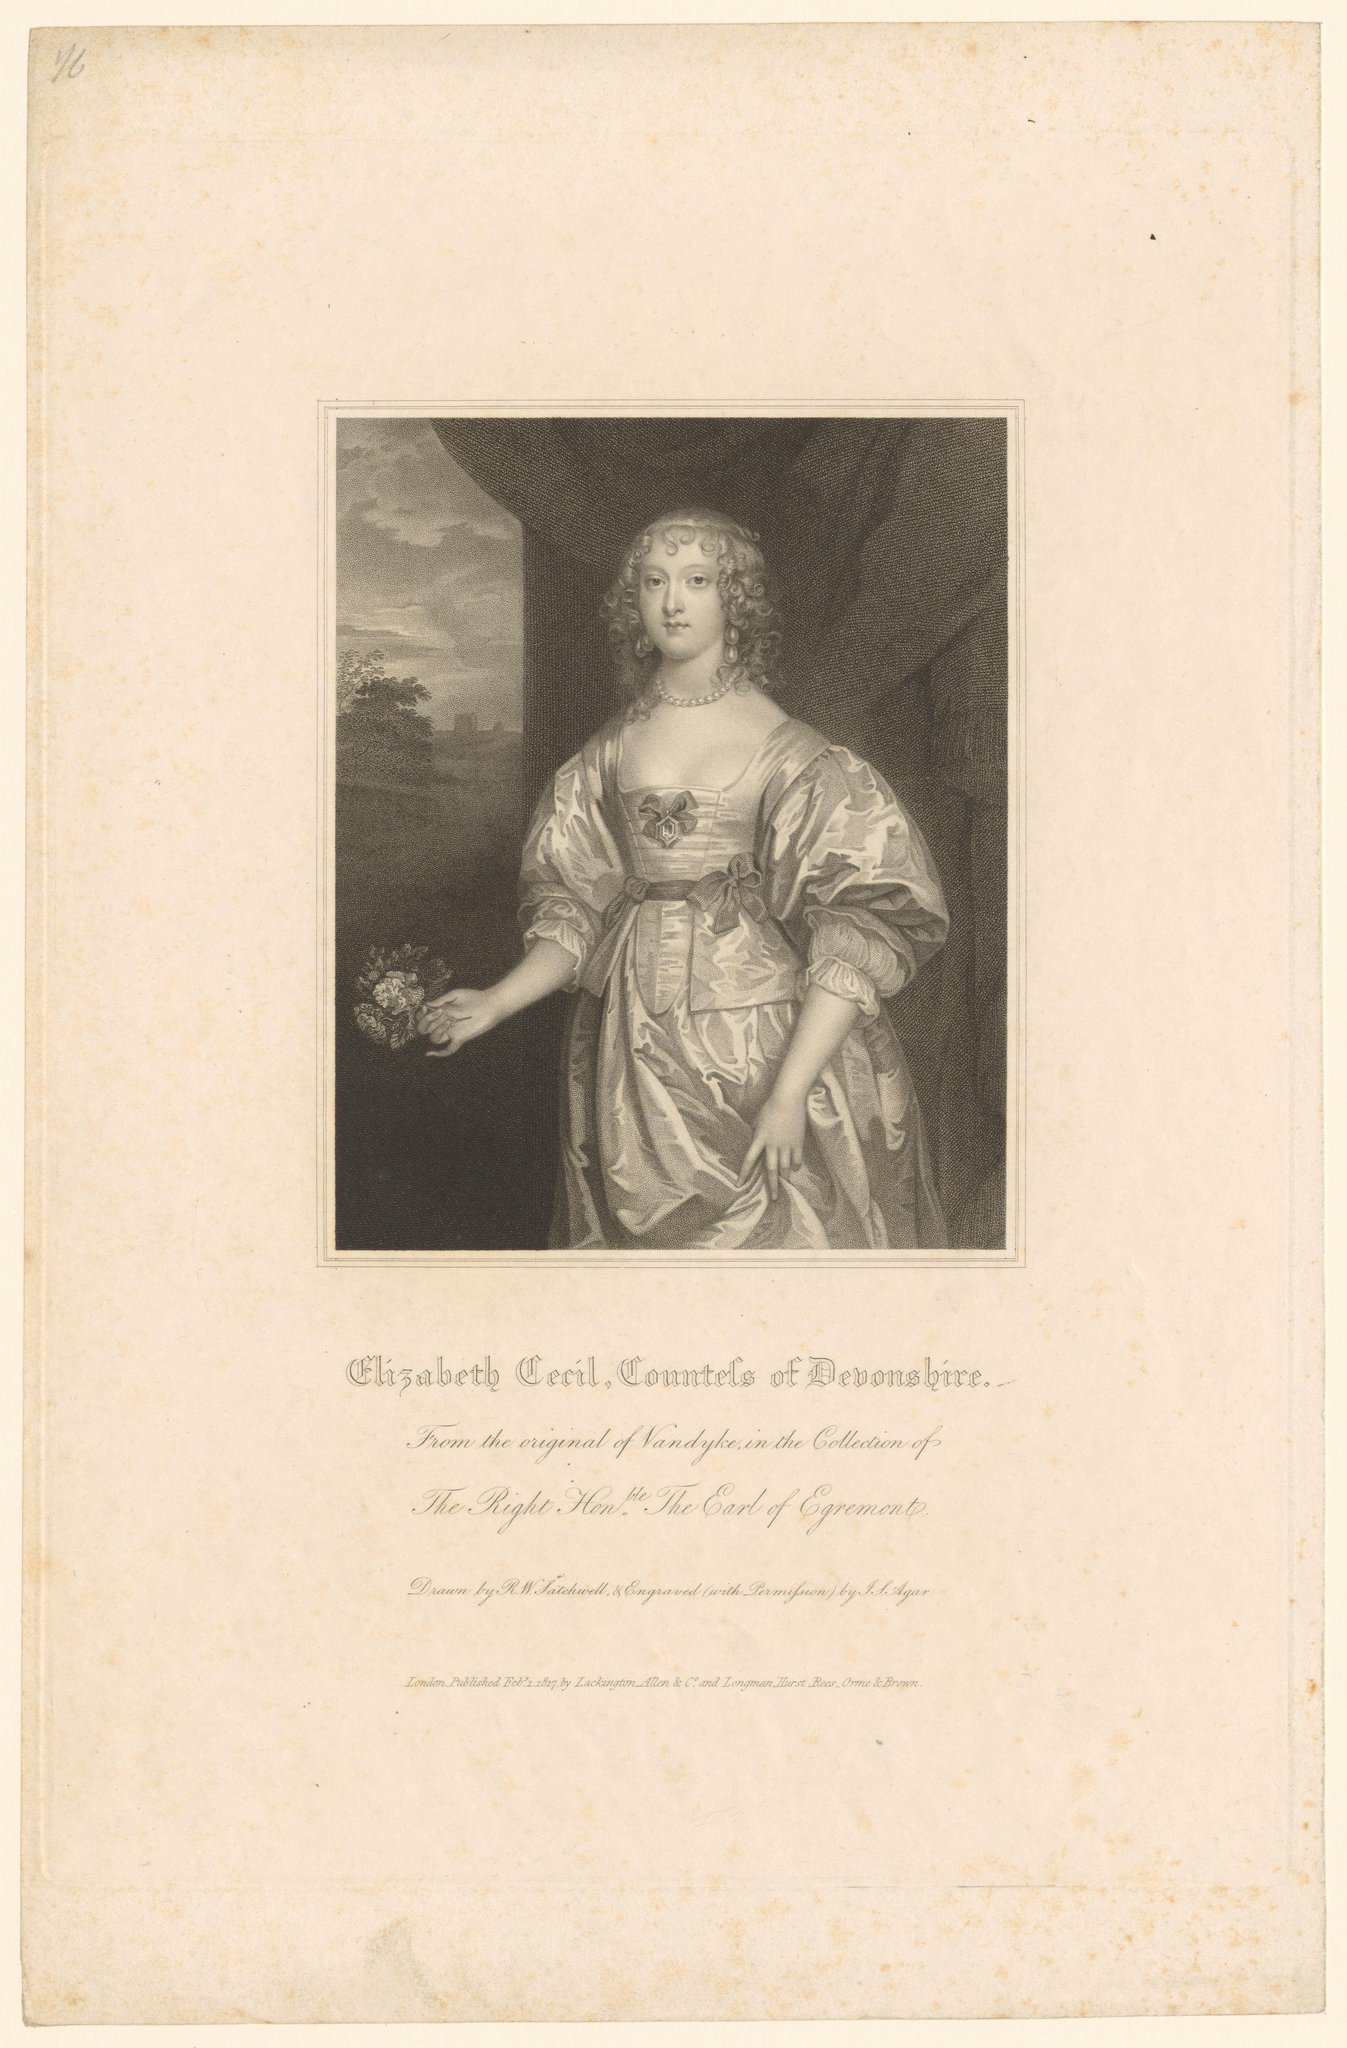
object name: print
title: Elizabeth Cecil, Countess of Devonshire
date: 1817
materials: paper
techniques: etching, engraving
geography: london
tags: elizabeth cavendish (gravin van devonshire), historical persons, standing figure - aa - female human figure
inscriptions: collector's mark: Lugt 2228